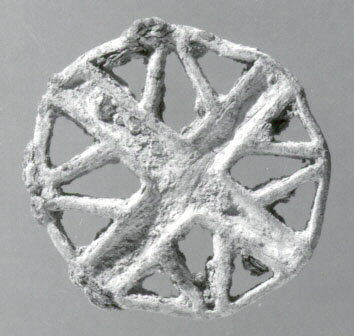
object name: stamp seal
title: Compartmented stamp seal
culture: bactria-margiana archaeological complex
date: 2333-1668 BCE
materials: copper alloy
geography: bactria-margiana